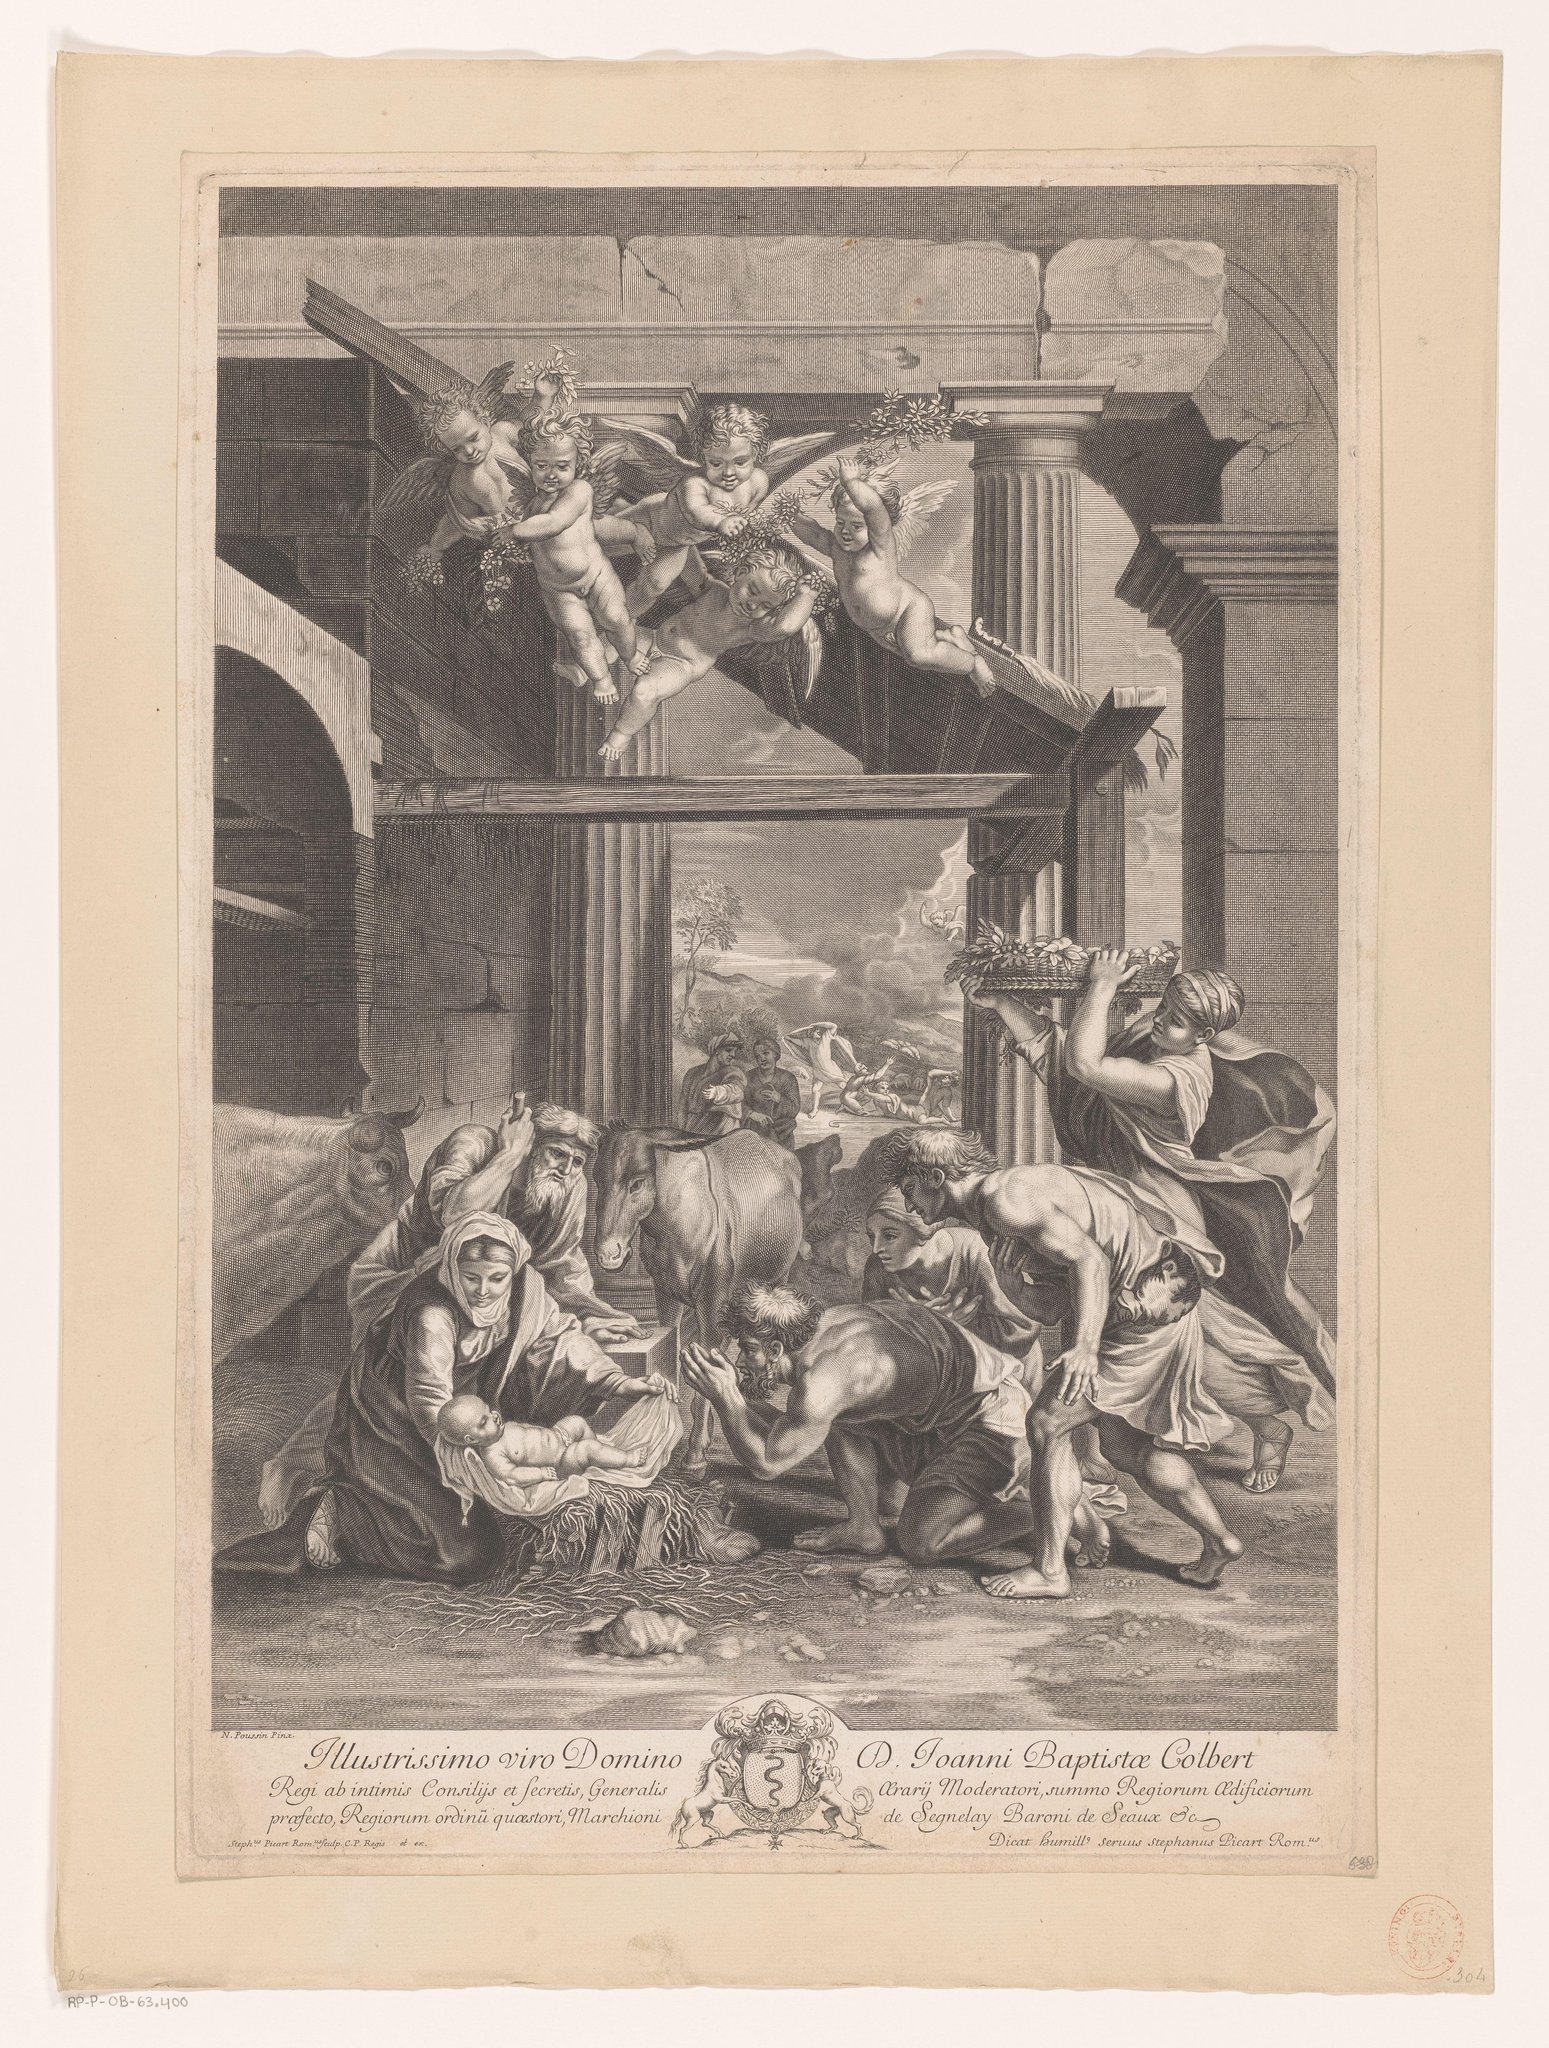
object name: print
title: Aanbidding door de herders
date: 1642-1721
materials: paper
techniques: engraving, etching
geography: france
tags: adoration of the christ-child by the shepherds; mary and joseph present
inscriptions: collector's mark: Lugt 240